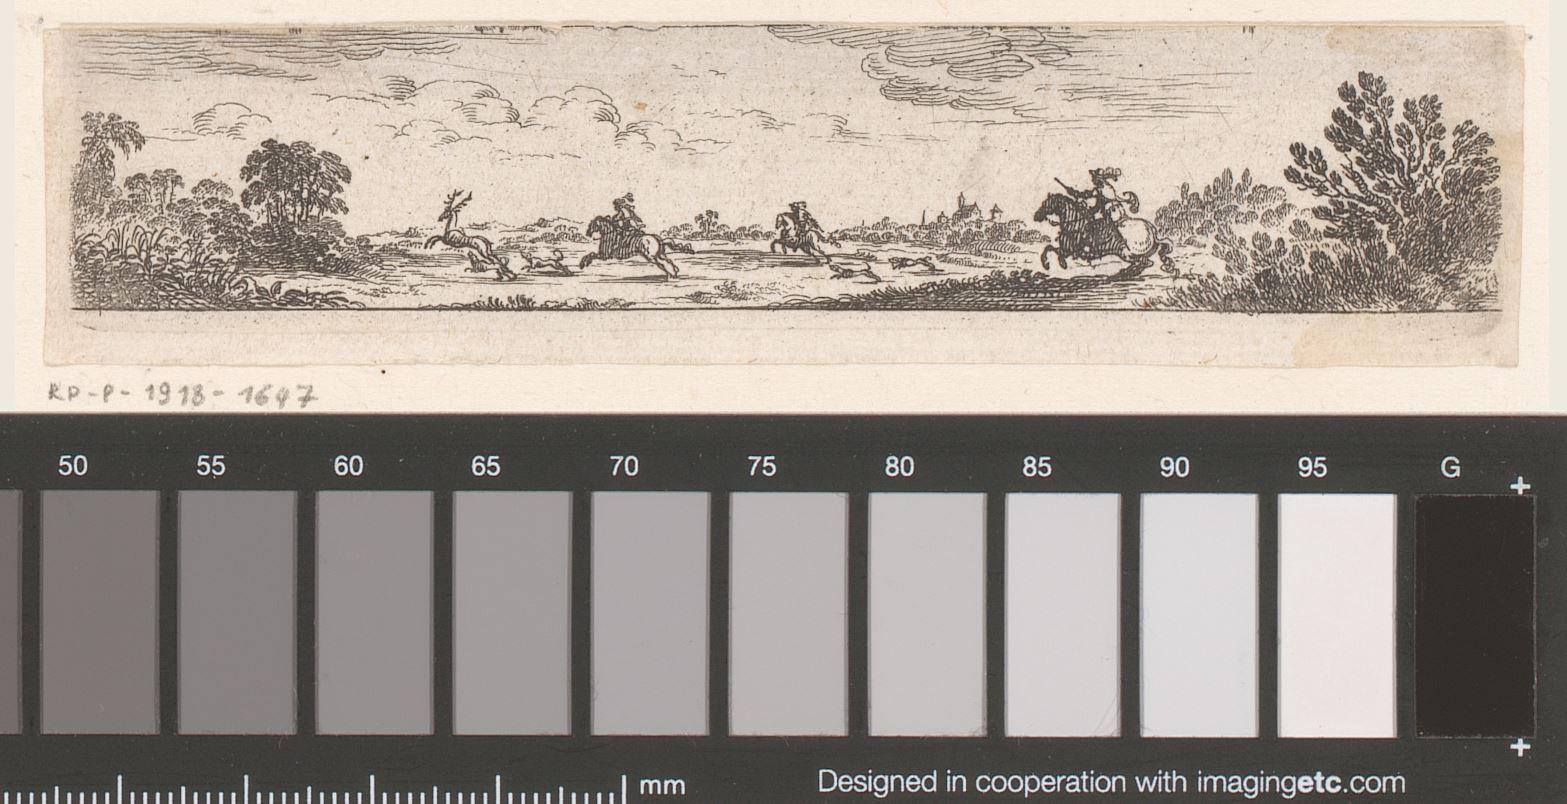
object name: print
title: Vignetten met buitentaferelen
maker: nicolas cochin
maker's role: print maker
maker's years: 1610-1686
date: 1620-1686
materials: paper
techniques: etching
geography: france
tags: hoofed animals: deer, landscapes, hunters hunting (n.b.: in 1988-1990 this notation denoted the concept of 43c11421 'hunters resting during the hunt')